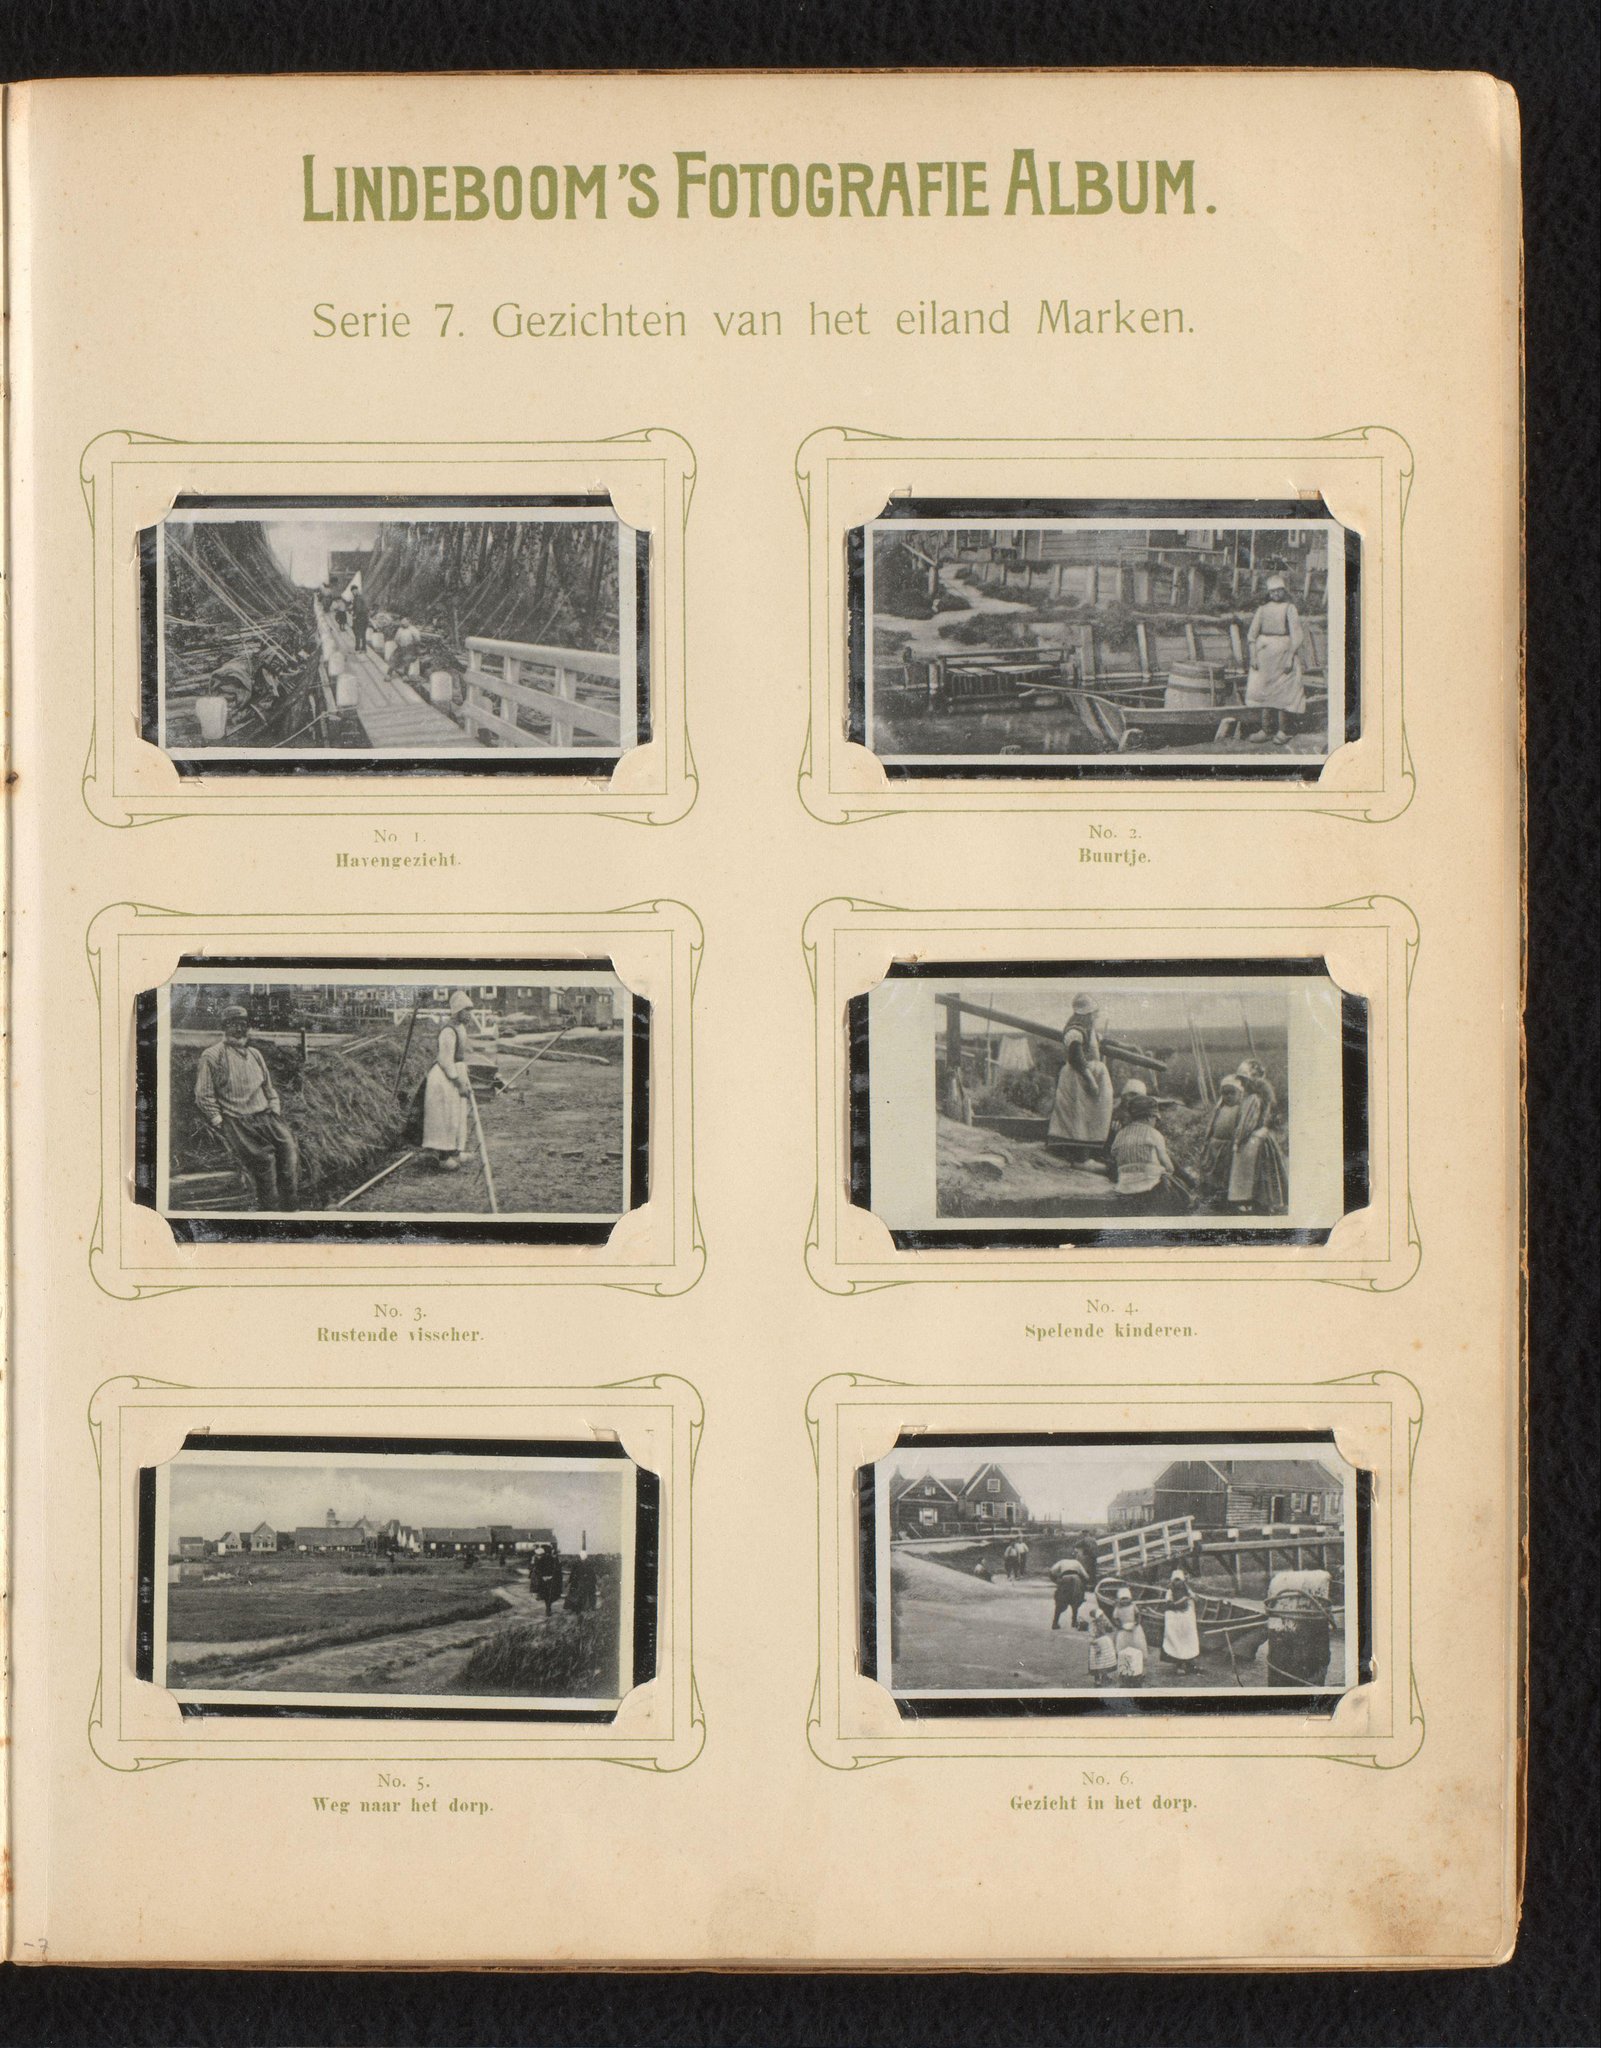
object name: album leaf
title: Zes reproducties van foto's van Marken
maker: Anonymous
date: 1905-1906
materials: cardboard, paper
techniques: photograph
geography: amsterdam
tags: village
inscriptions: inscription: ‘Serie 7.’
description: Dergelijke prenten stonden bekend als 'zwartjes'. Men verkreeg ze bij aanschaf van bepaalde merken thee, cacao, sigaretten, beschuit, etc. om te verzamelen. Er waren speciaal voor de 'zwartjes' vervaardigde verzamelalbums in omloop.